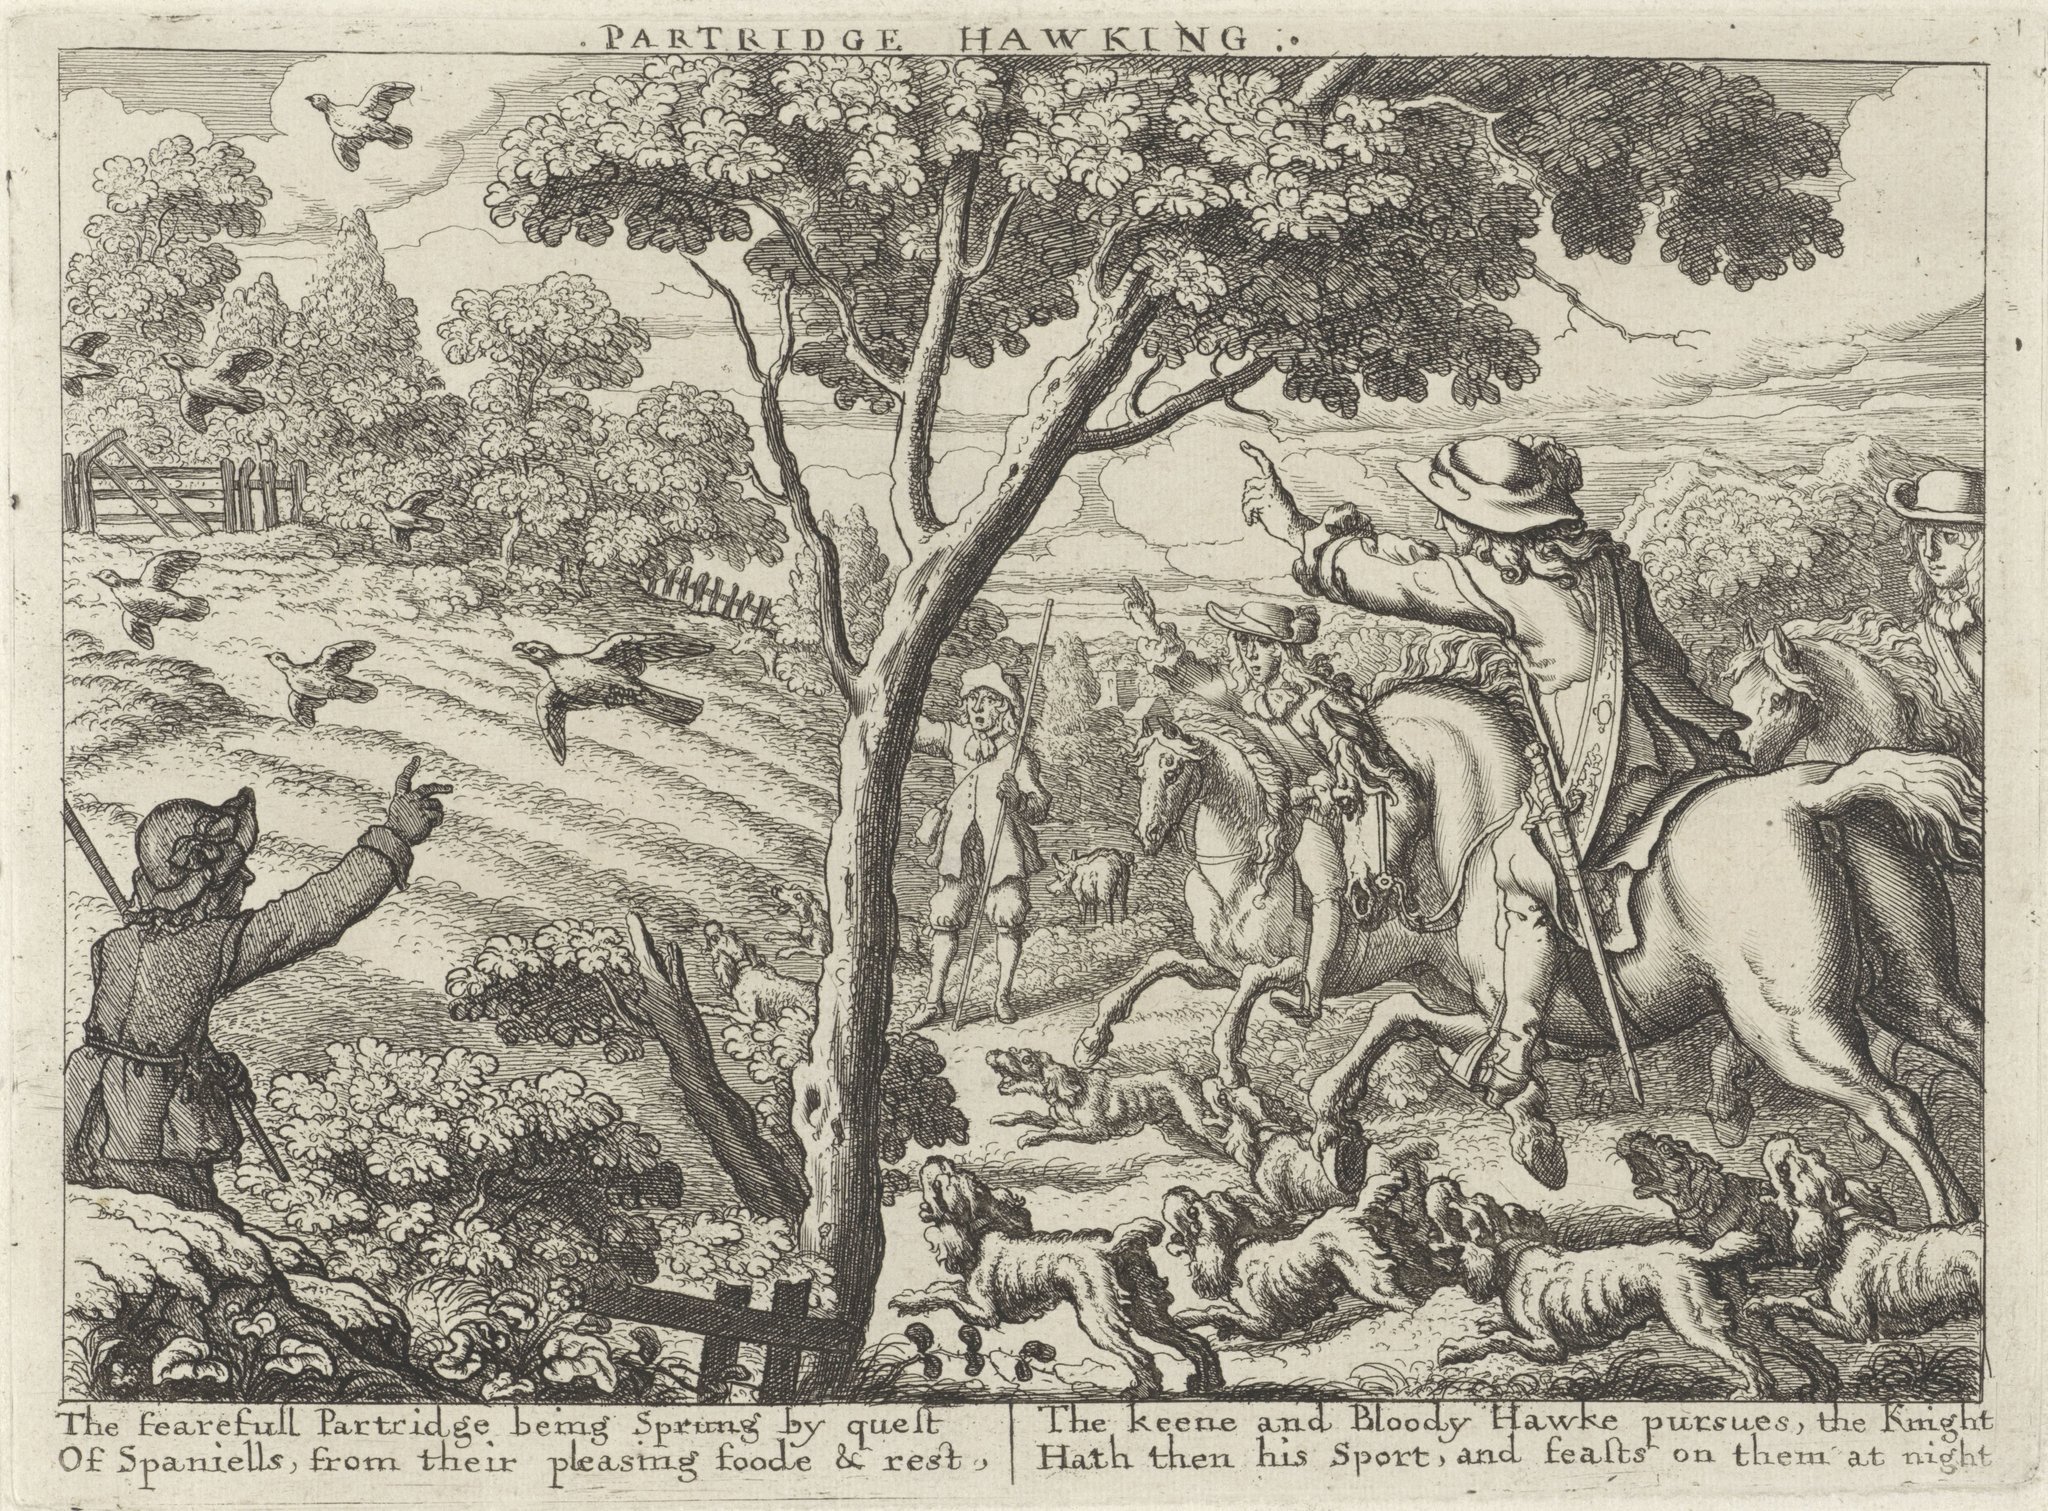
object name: print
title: Severall Wayes of Hunting, Hawking, and Fishing, According to the English Manner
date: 1671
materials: paper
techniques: etching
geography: london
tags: hunting dogs, walker and runner birds: partridge, bird hunting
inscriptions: collector's mark: Lugt 2760, collector's mark: Lugt 2228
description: De prent maakt deel uit van de twaalfdelige serie: Severall Wayes of Hunting, Hawking, and Fishing, According to the English Manner, 1671. Vier van de twaalf prenten uit deze serie zijn van Hollar's hand. De resterende acht prenten zijn ongesigneerd en waarschijnlijk door Richard Gaywood (zie NHG(2009)).